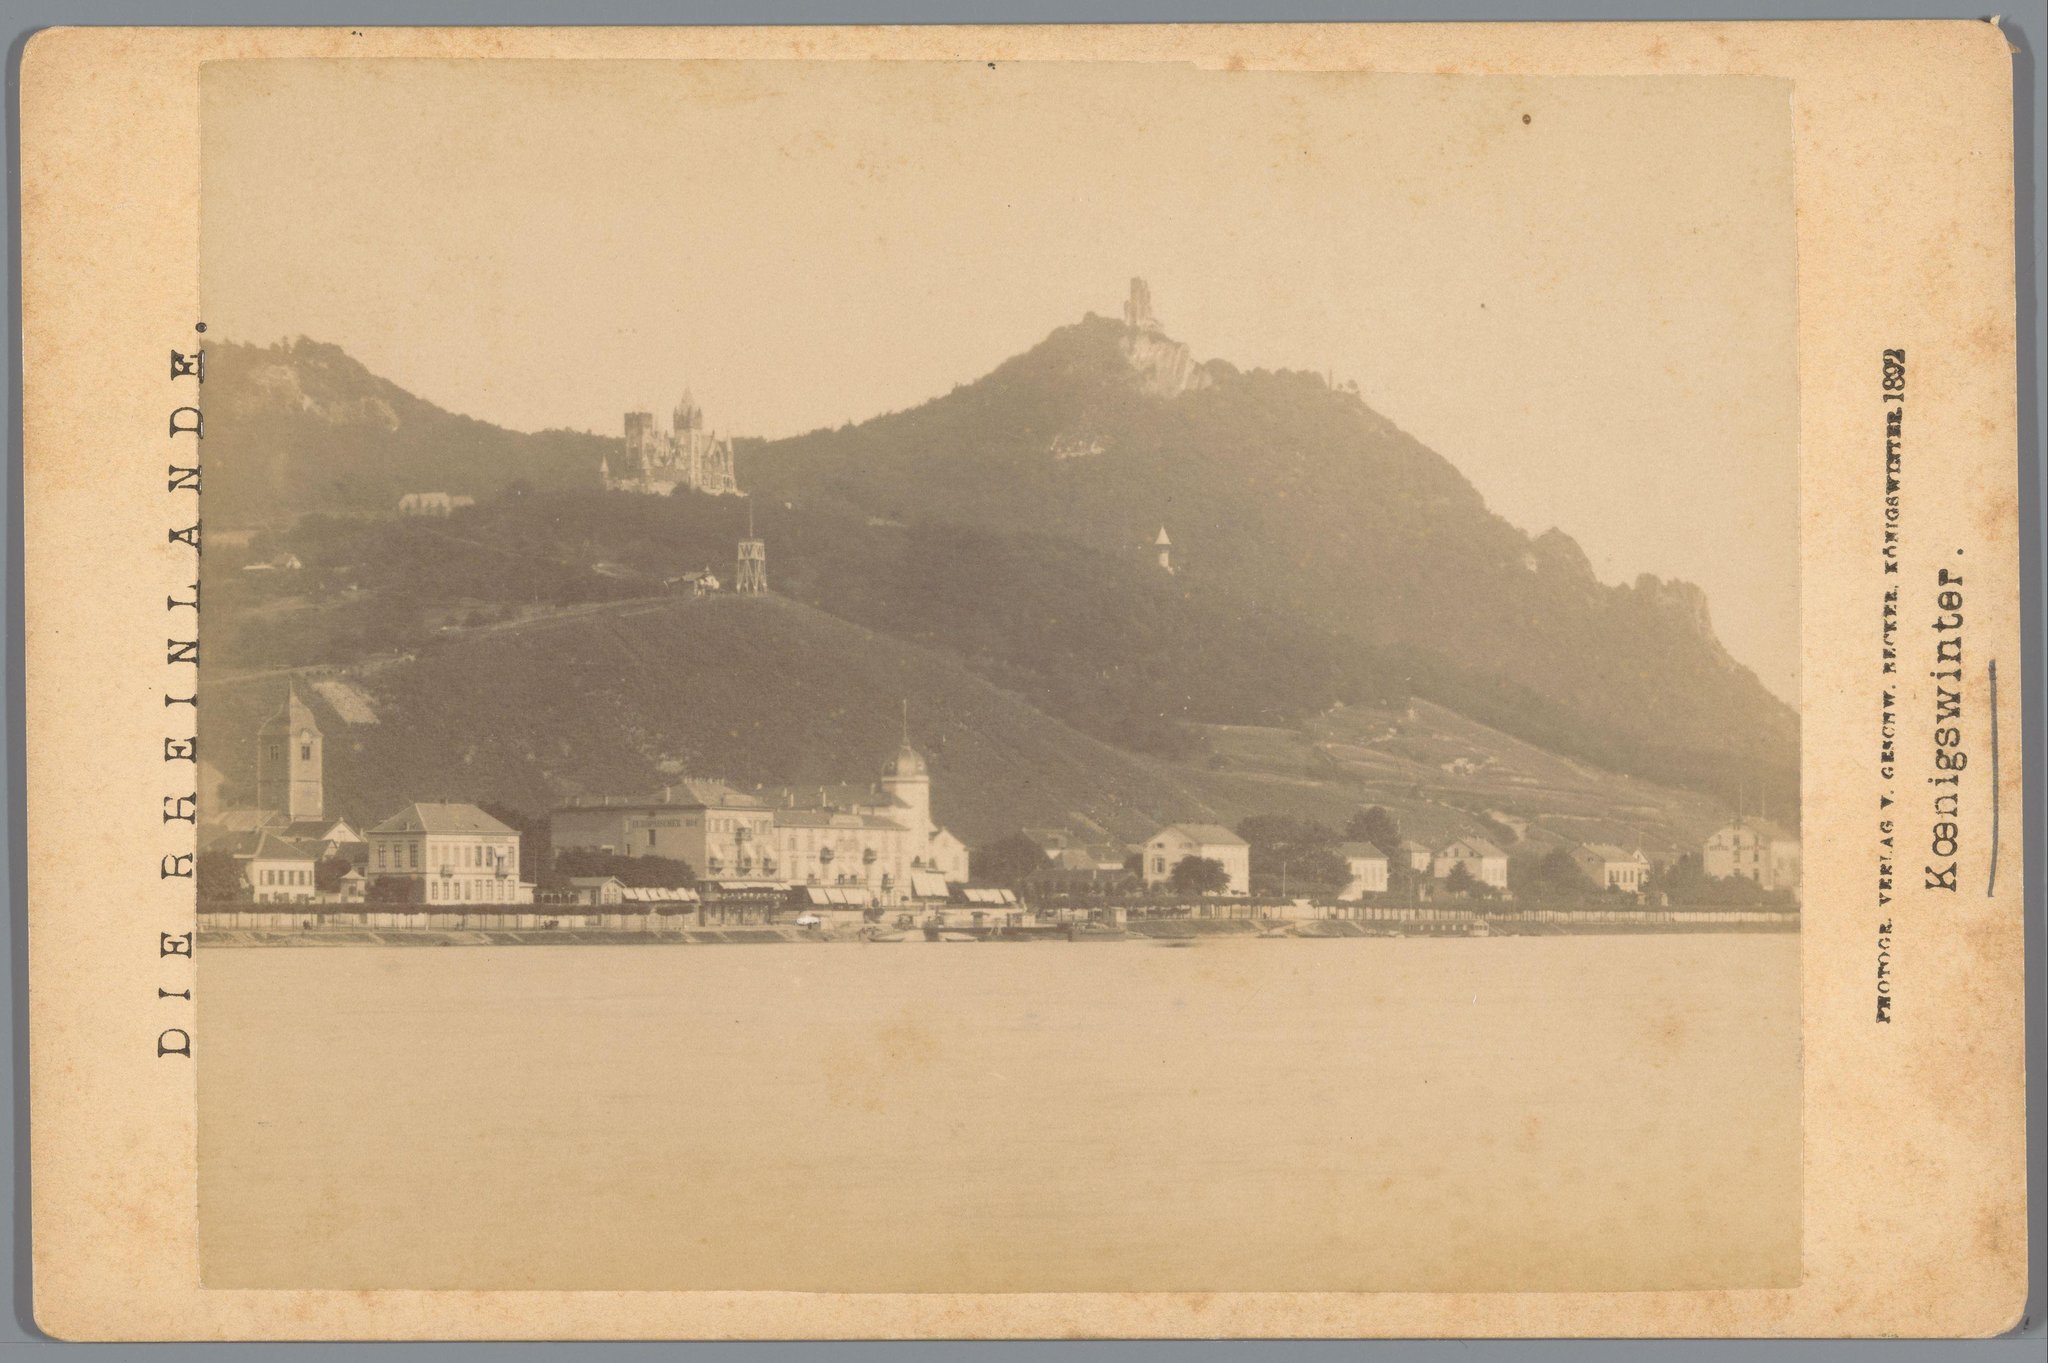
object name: cabinet photograph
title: Gezicht op Königswinter en de Rijn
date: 1892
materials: cardboard, photographic support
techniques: albumen print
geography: königswinter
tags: city-view in general; 'veduta', river